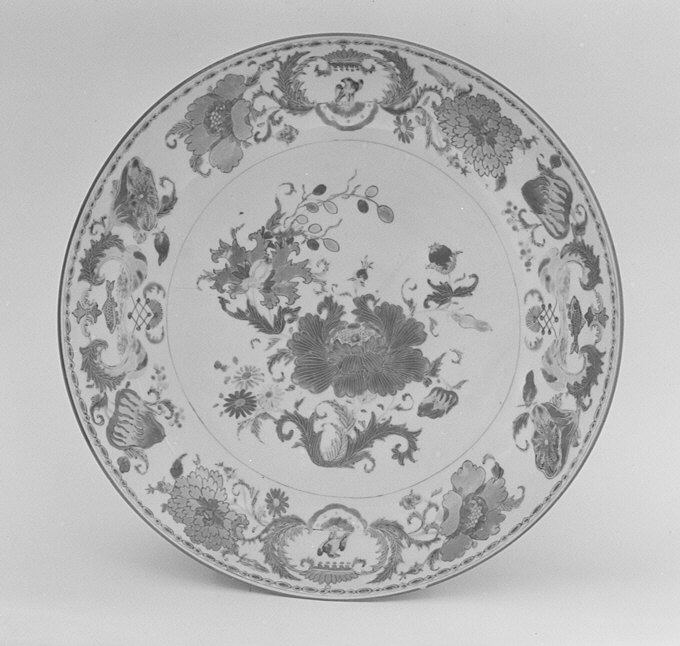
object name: plate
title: Plate (part of a set)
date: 1725-1740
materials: hard paste porcelain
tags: birds,flowers,coat of arms